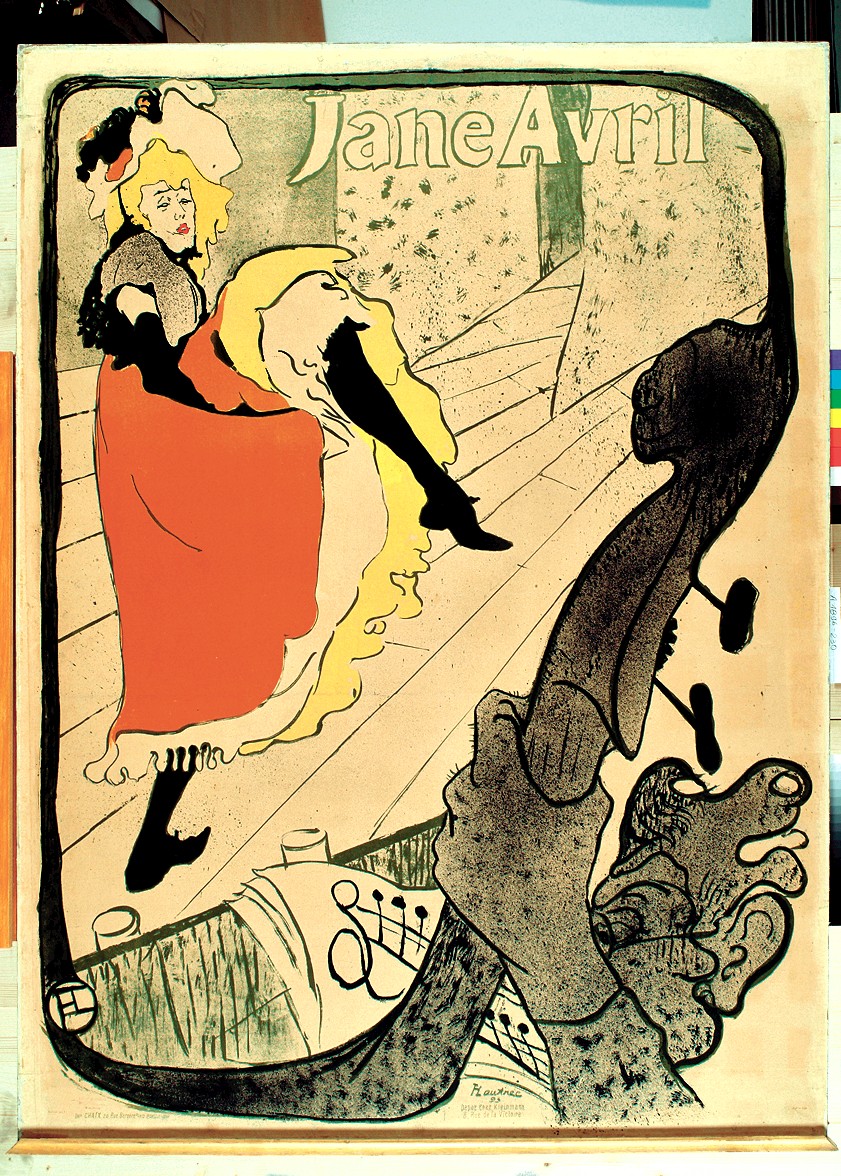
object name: print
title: Jane Avril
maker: henri de toulouse-lautrec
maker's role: artist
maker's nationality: french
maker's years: 1864-1901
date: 1893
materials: paper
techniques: lithograph, printing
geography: france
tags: women,dancers